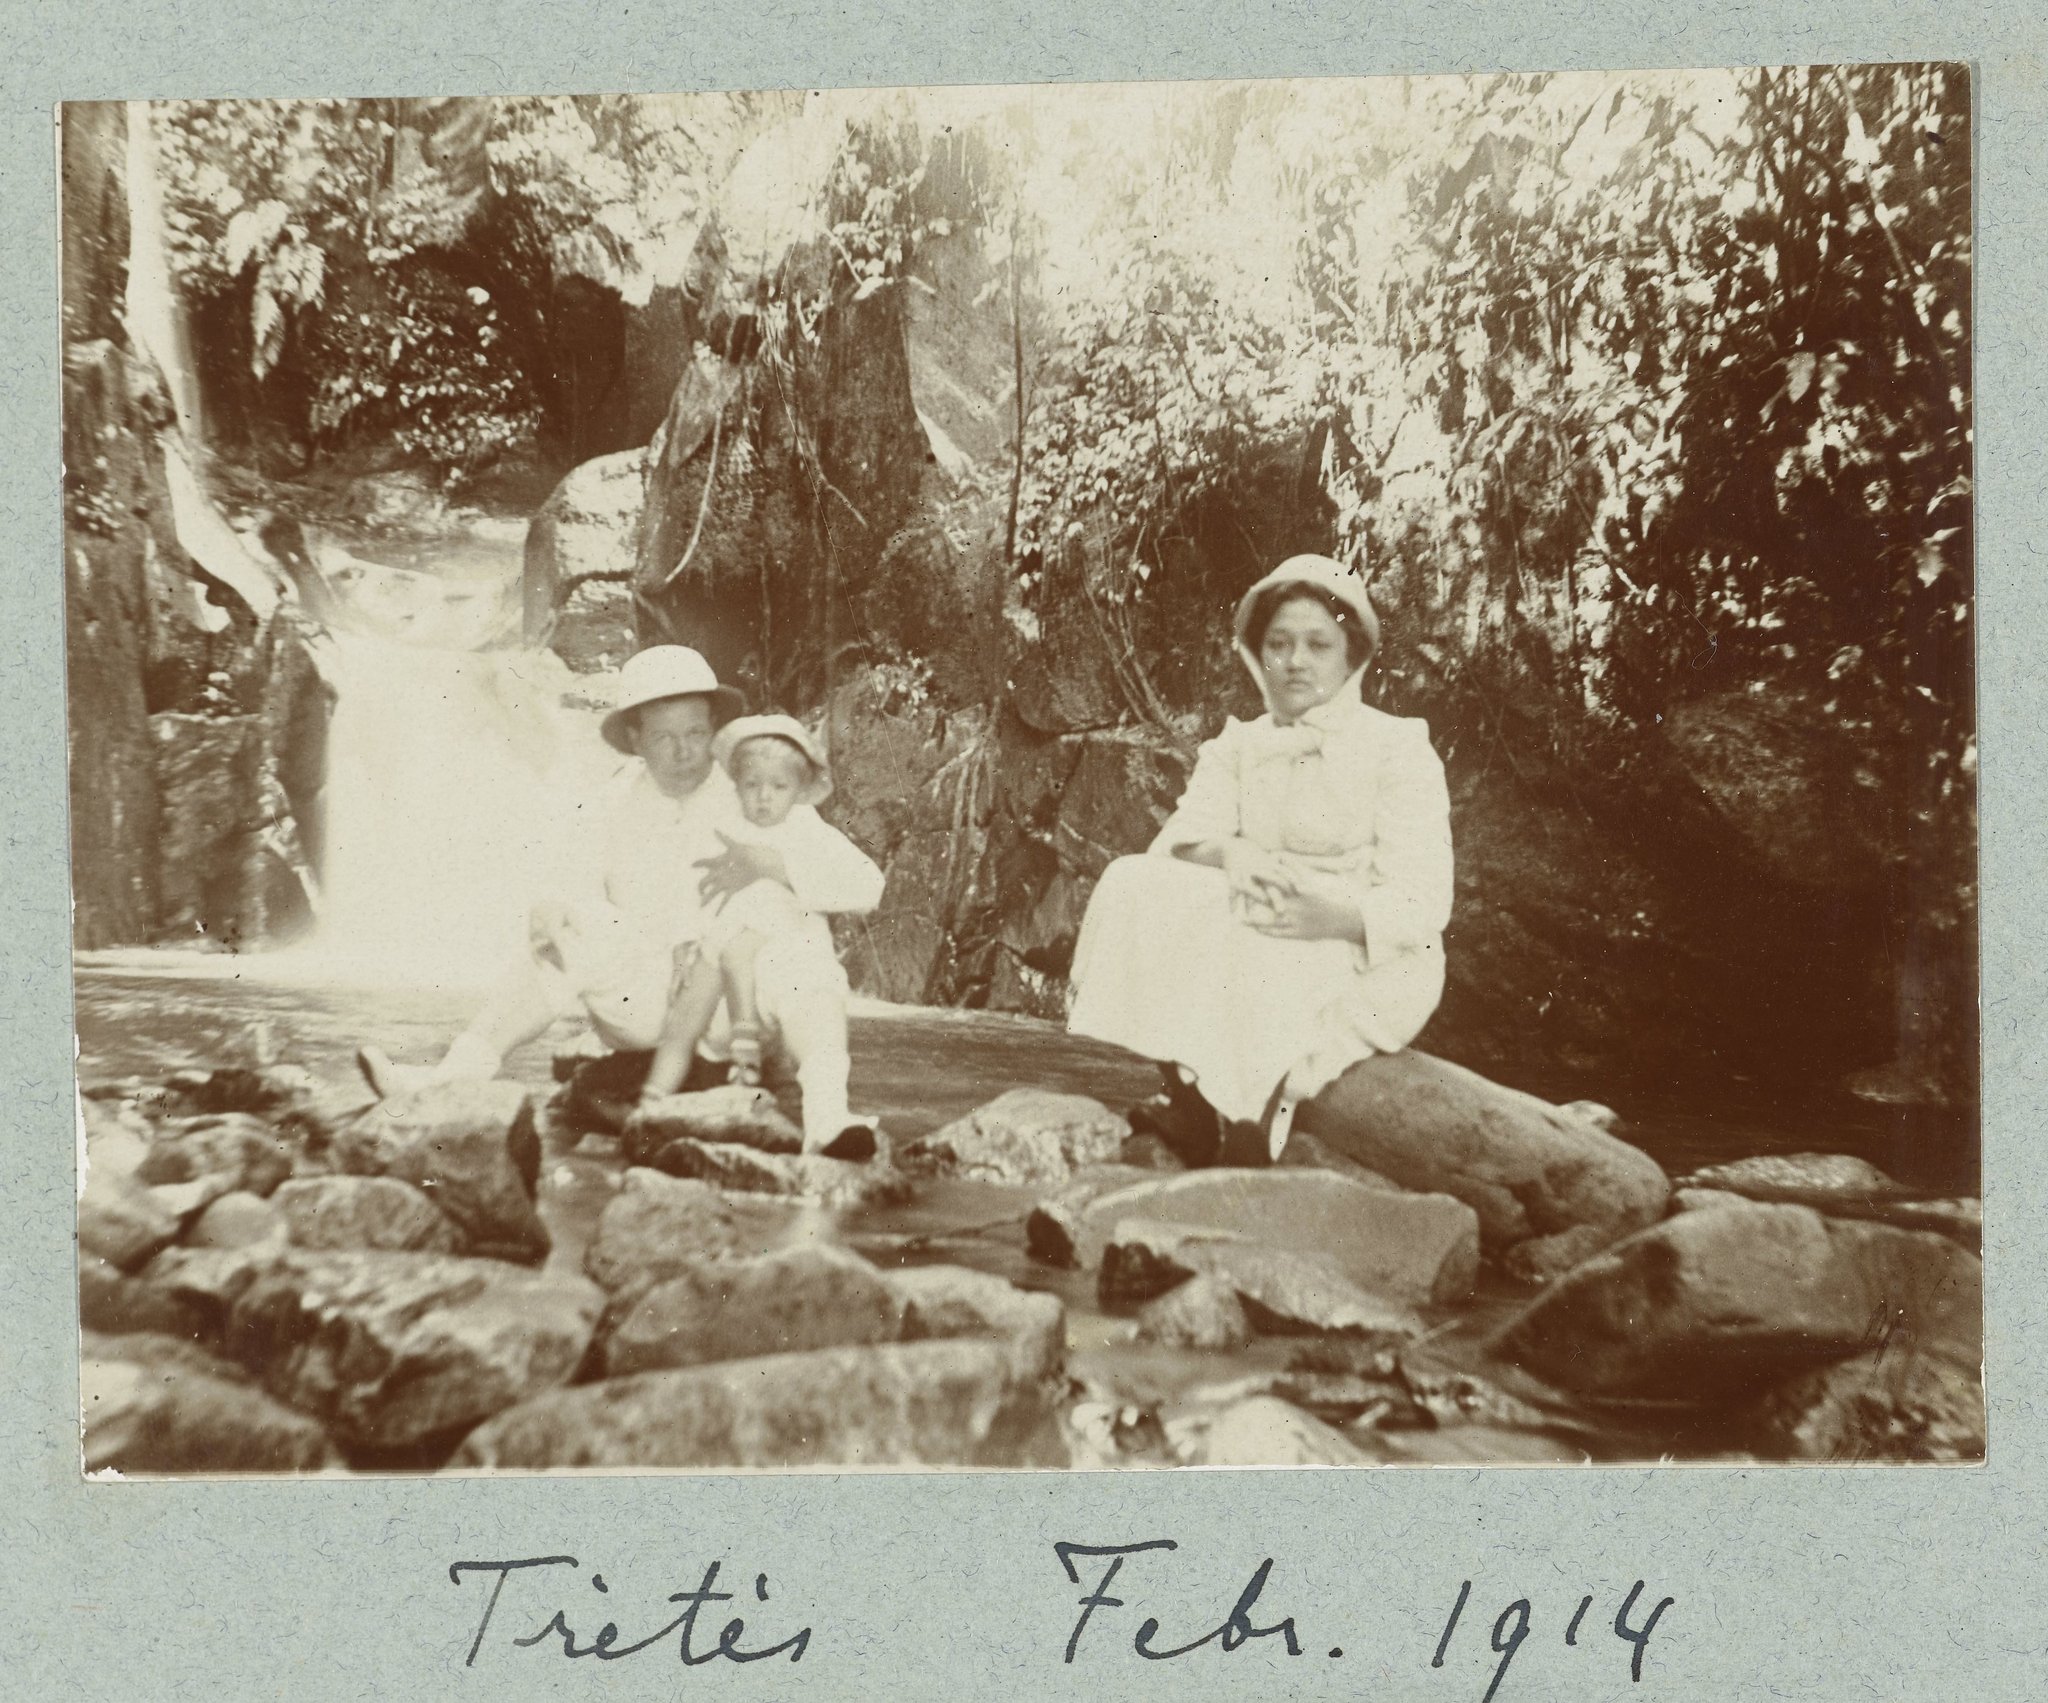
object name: photograph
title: Tretes Febr. 1914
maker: frits freerks fontein fz.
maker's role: fotograaf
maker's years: 1882-1928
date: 1912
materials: cardboard, paper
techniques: gelatin silver print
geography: netherlands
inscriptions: caption: ‘Tretes Febr. 1914’